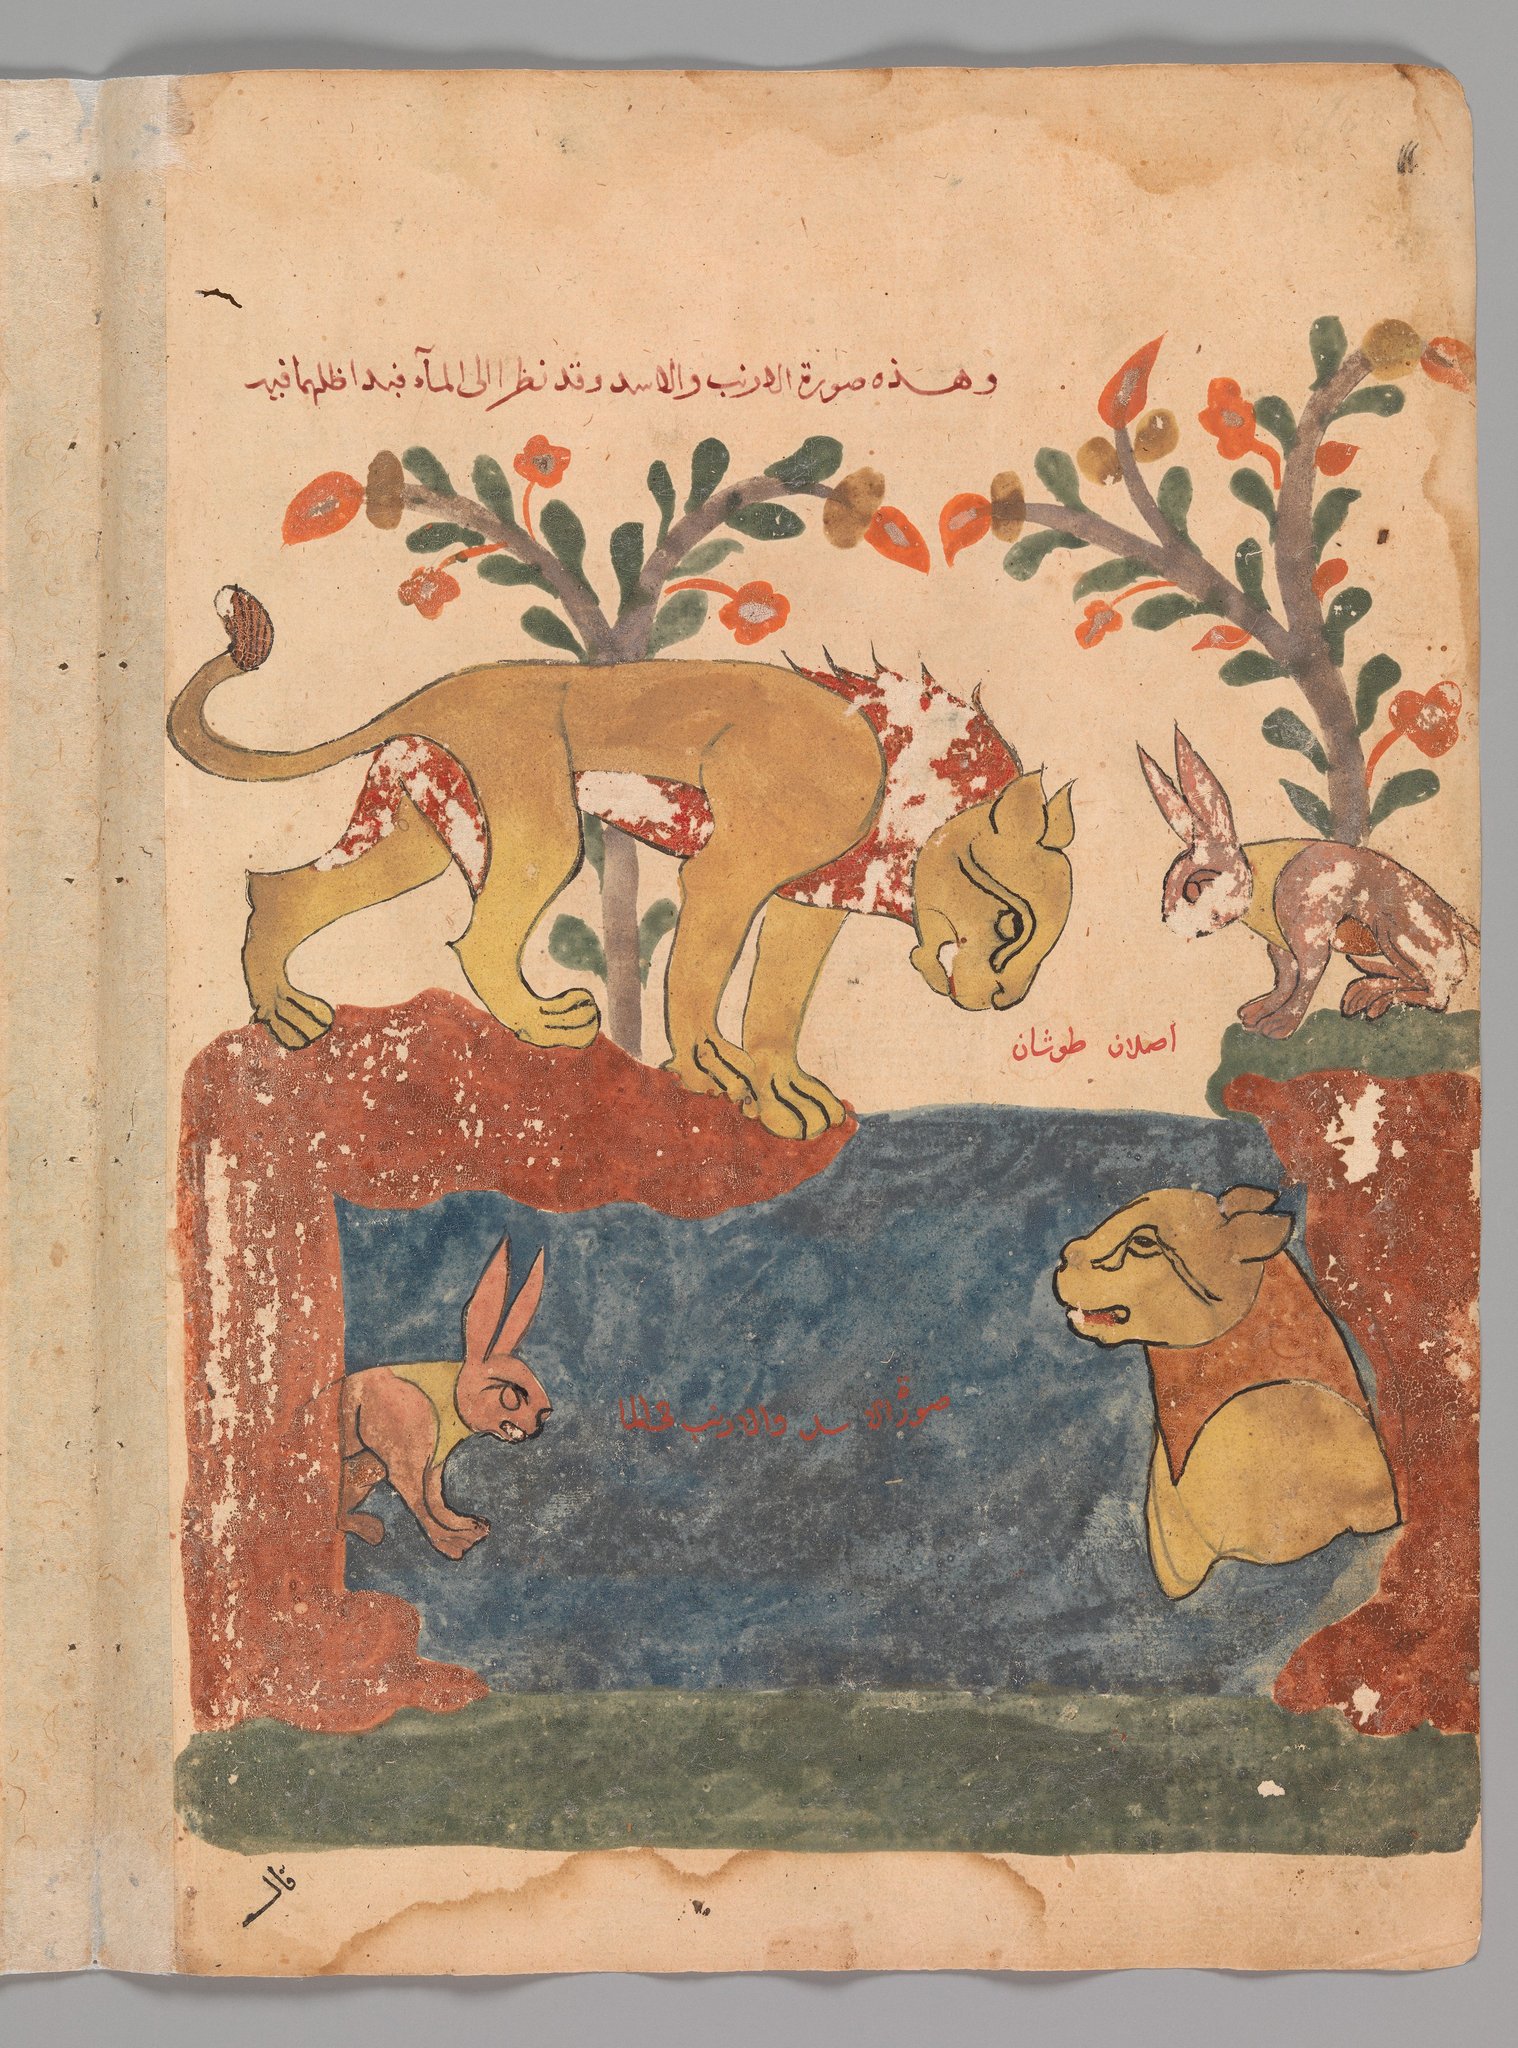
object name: folio from an illustrated manuscript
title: "The Hare, the Lion, and the Well", Folio from a Kalila wa Dimna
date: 1526-1550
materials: ink, paper, watercolor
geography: india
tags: wells,lions,rabbits